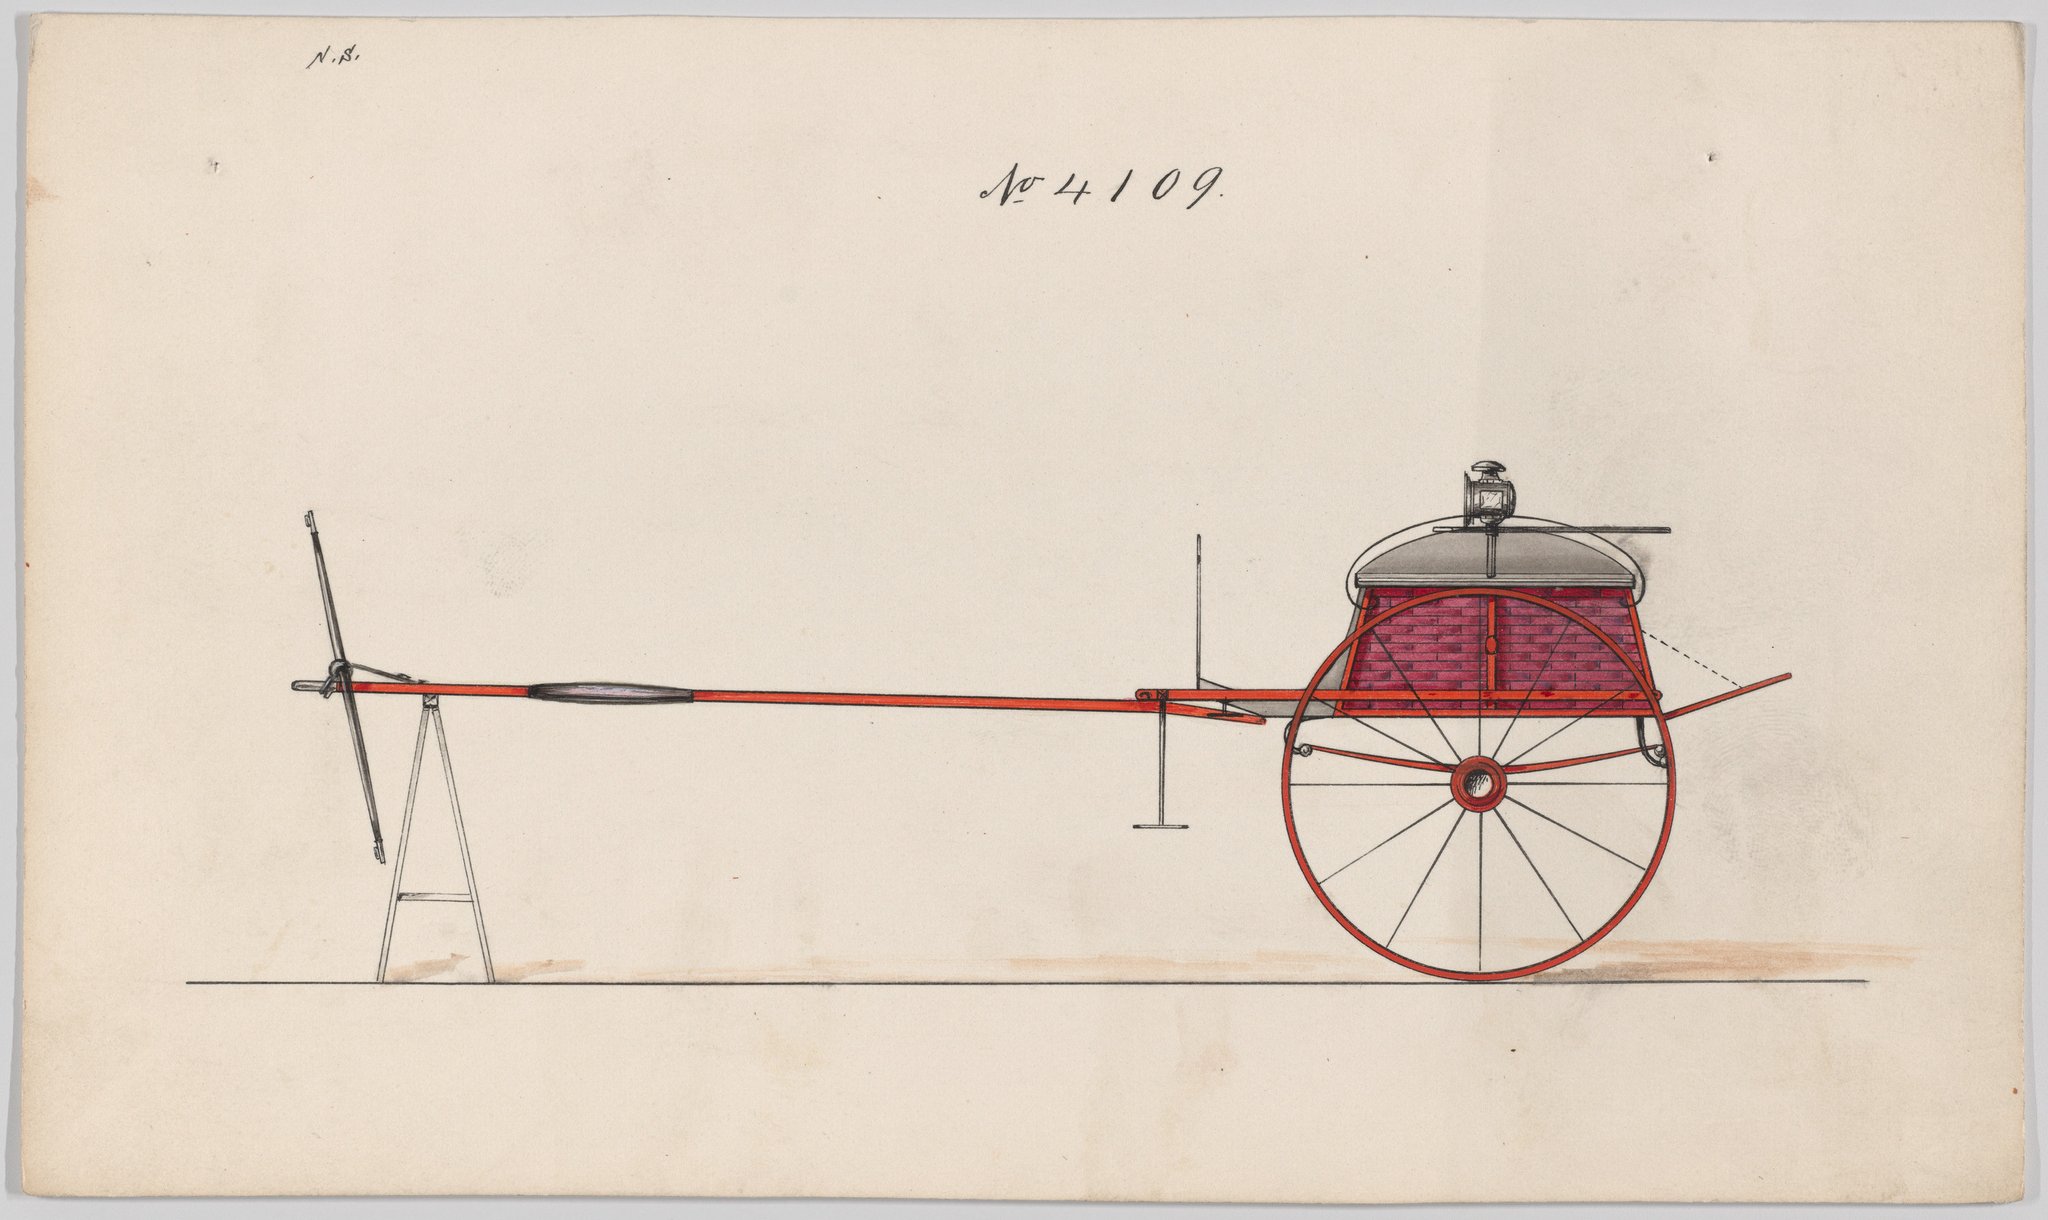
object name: drawing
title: Design for Dog Cart or 2 Wheeler, no. 4109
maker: brewster & co.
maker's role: manufacturer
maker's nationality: american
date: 1890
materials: gouache, gum arabic, ink, watercolor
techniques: pen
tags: carriages